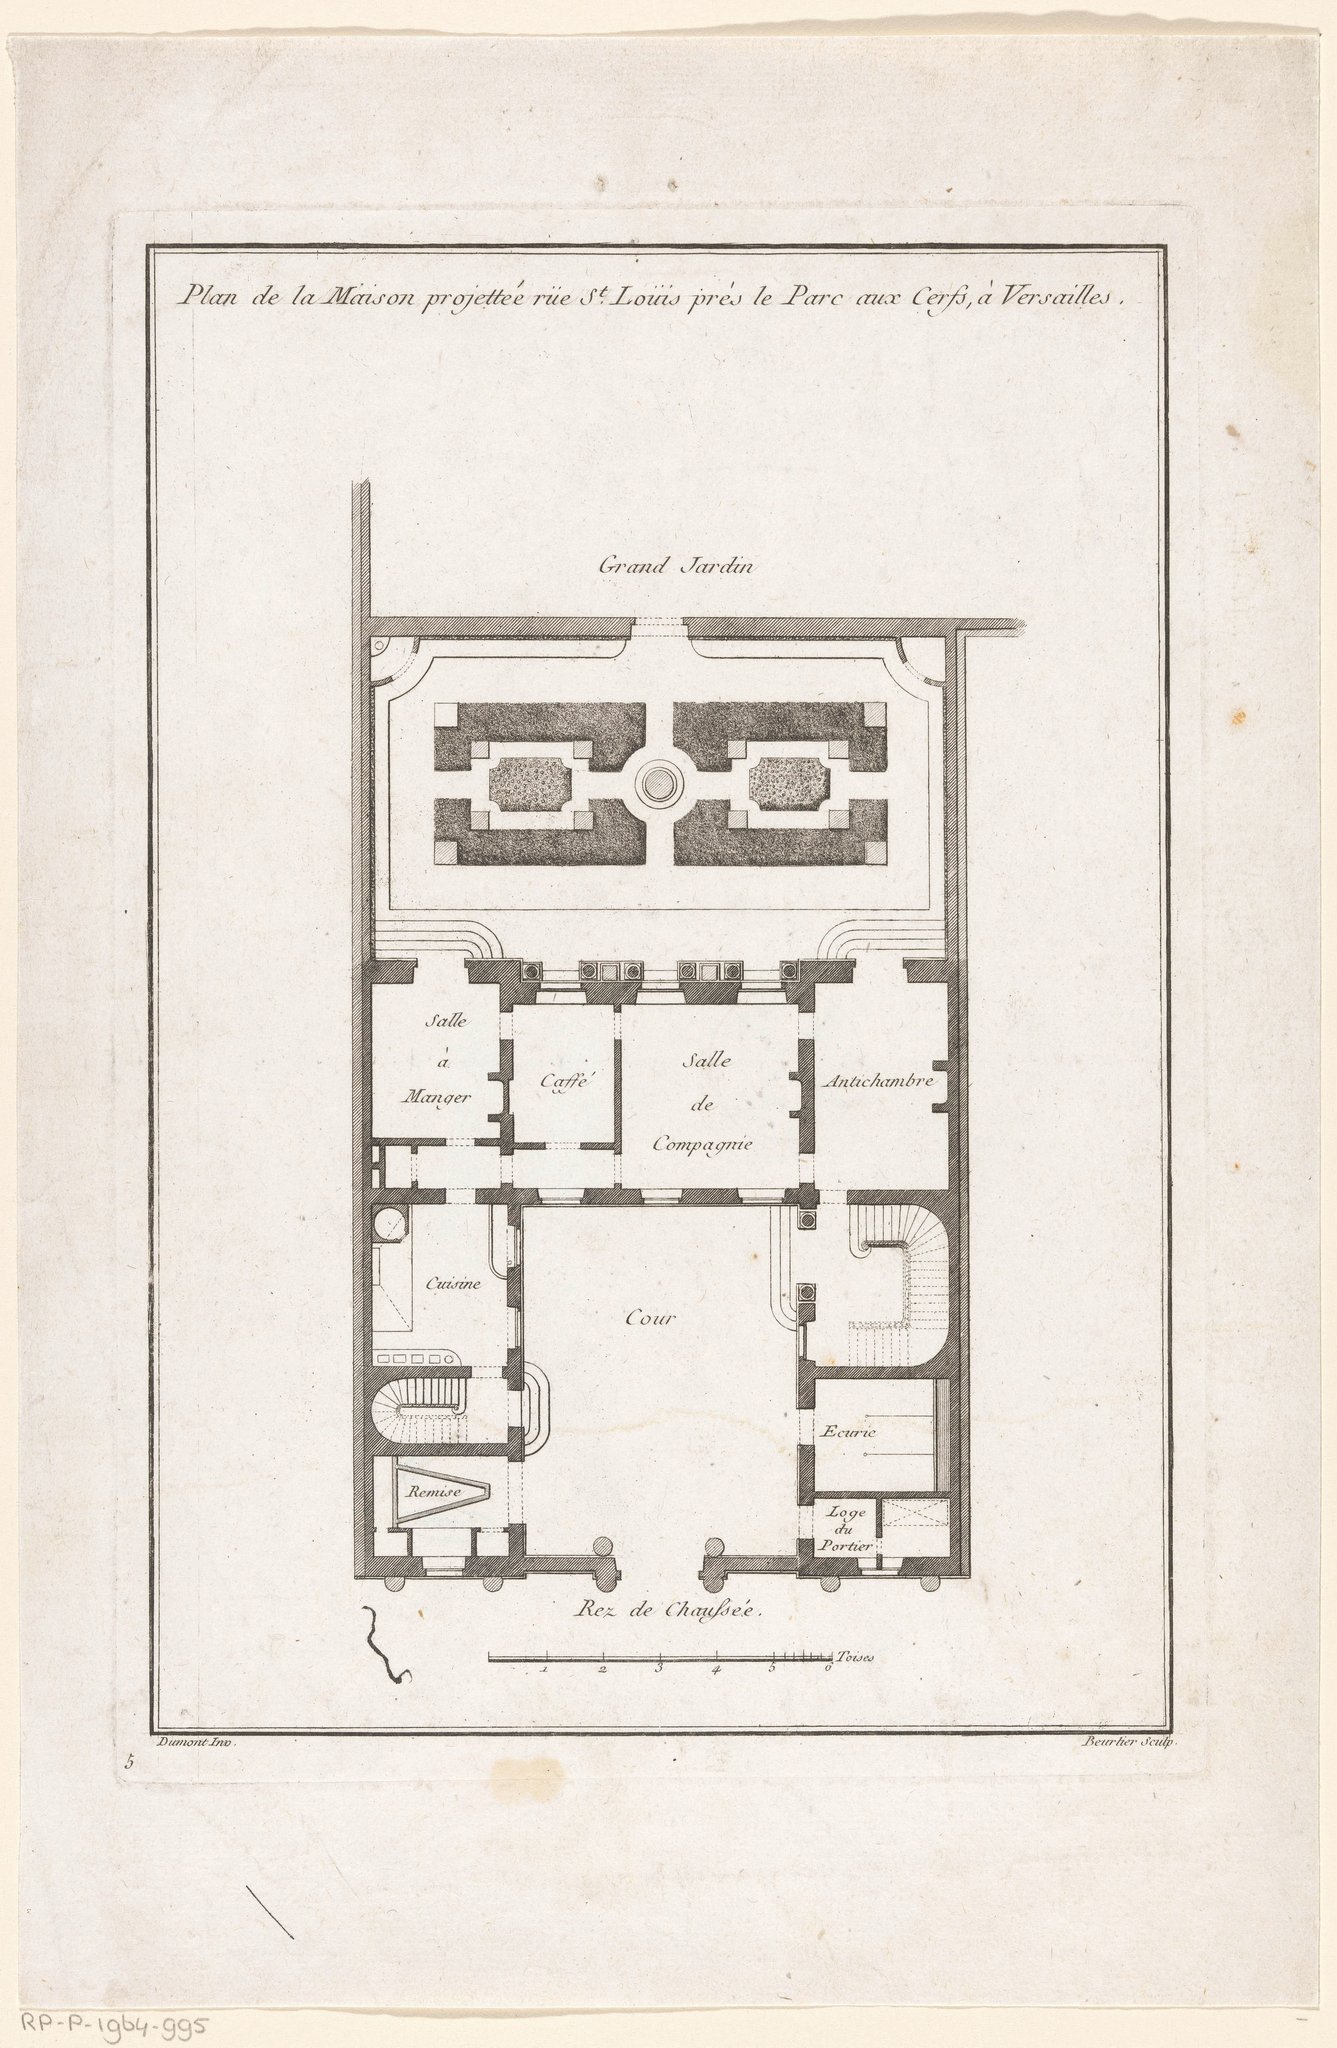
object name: ornament print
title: Plattegrond van een huis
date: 1730-1790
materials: paper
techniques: engraving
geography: paris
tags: plan ~ architecture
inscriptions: collector's mark: Lugt 2760, collector's mark: Lugt 2228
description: Plattegrond van een huis met een tuin aan de achterzijde.